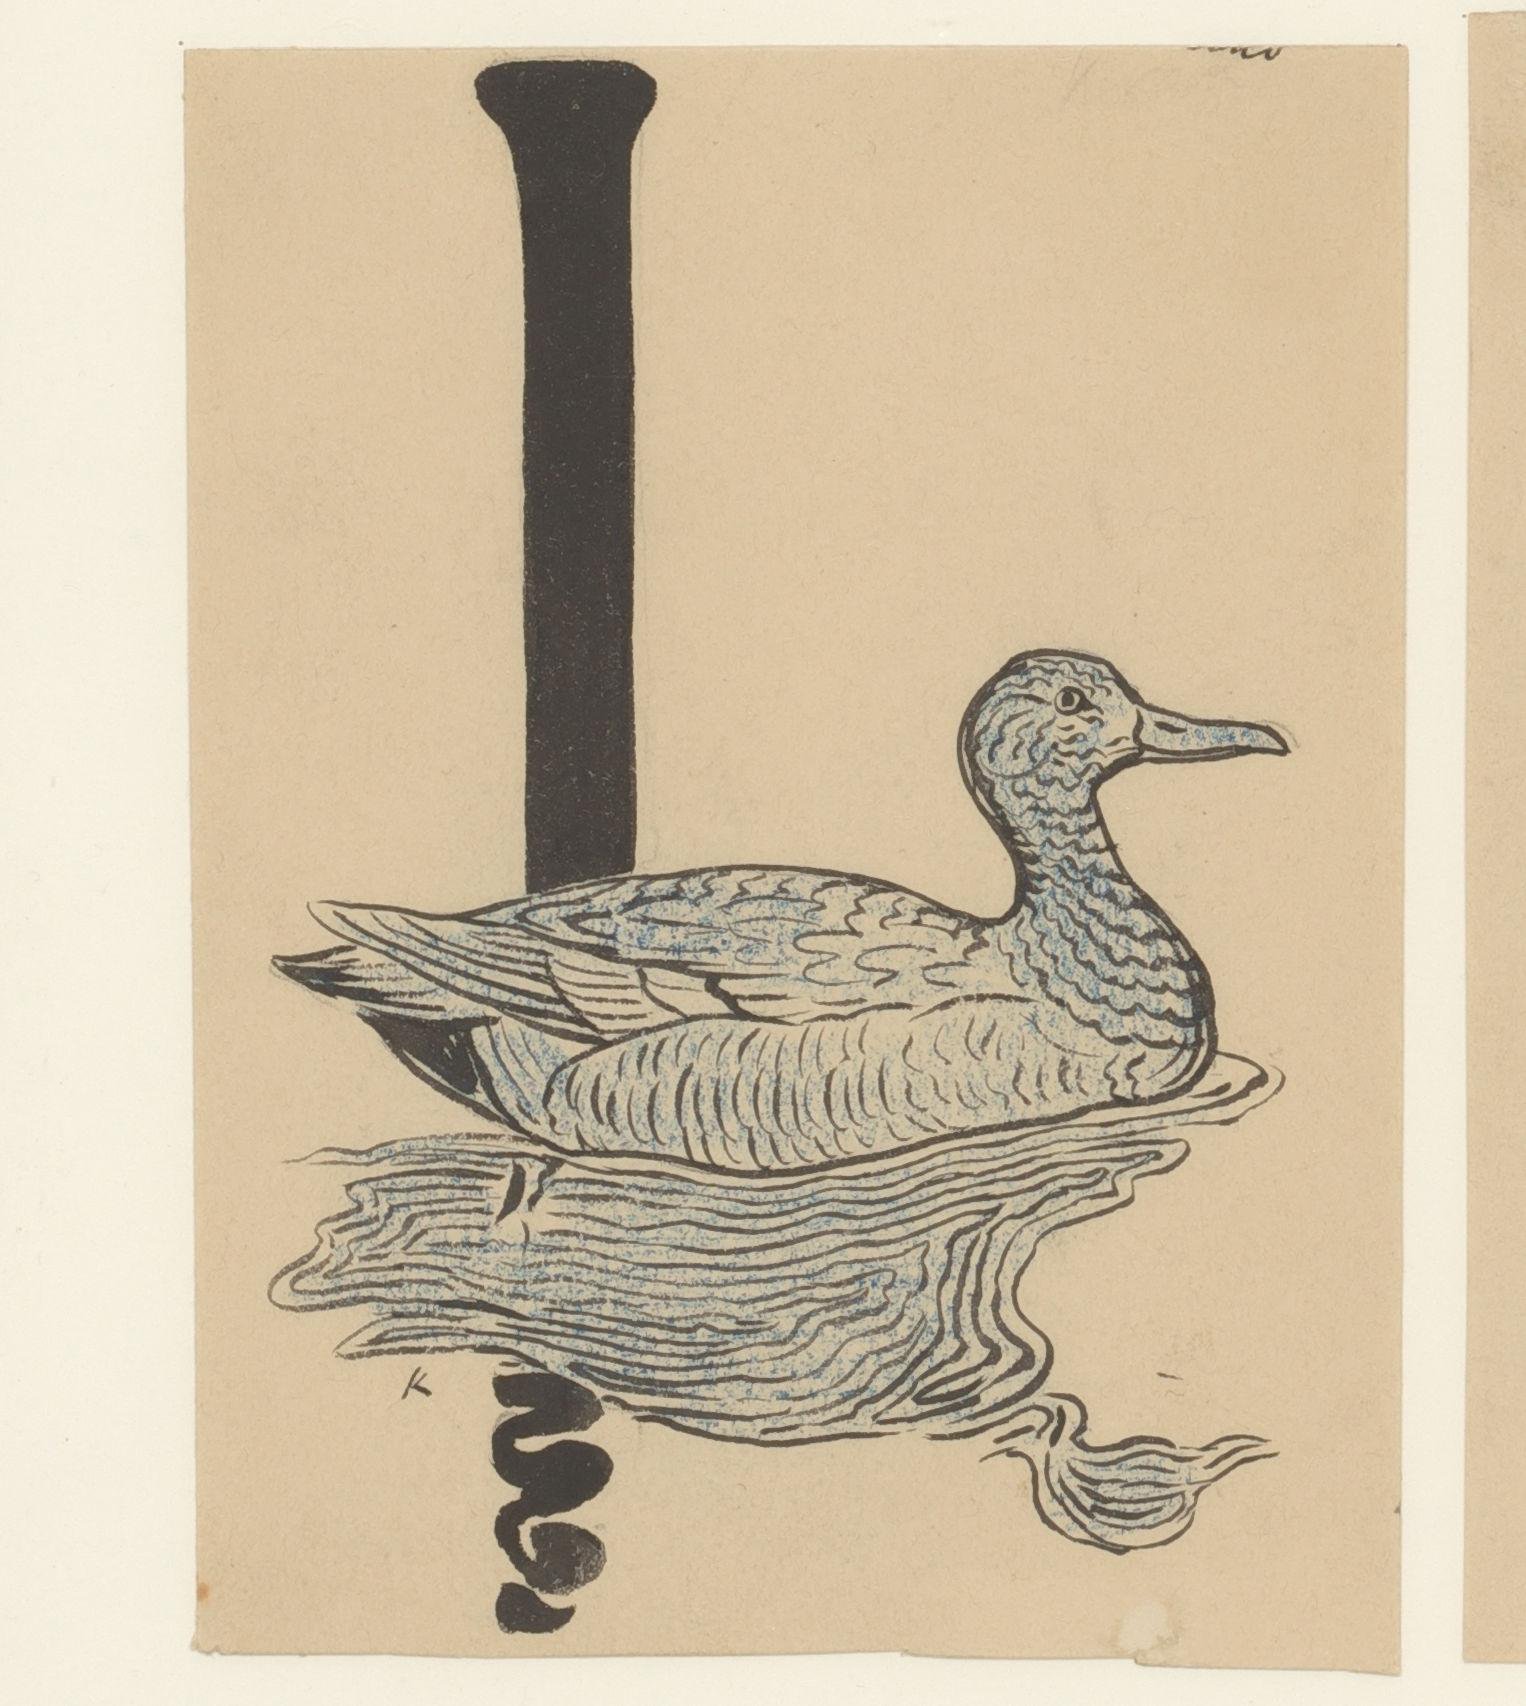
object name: drawing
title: Letter I met eend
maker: heinrich m. krabbé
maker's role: draughtsman, print maker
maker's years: 1868-1931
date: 1899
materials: ink, paper, pencil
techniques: brush, pen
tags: letters, alphabet, script, water-birds: duck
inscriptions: collector's mark: Lugt 1641, stamp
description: Onderwerpsrubrieken binnen de Atlas Zeden en Gewoonten: Handel, Nijverheid en Verkeer, Beroep en bedrijf, Mannelijk, Eet- en drinkwaren.